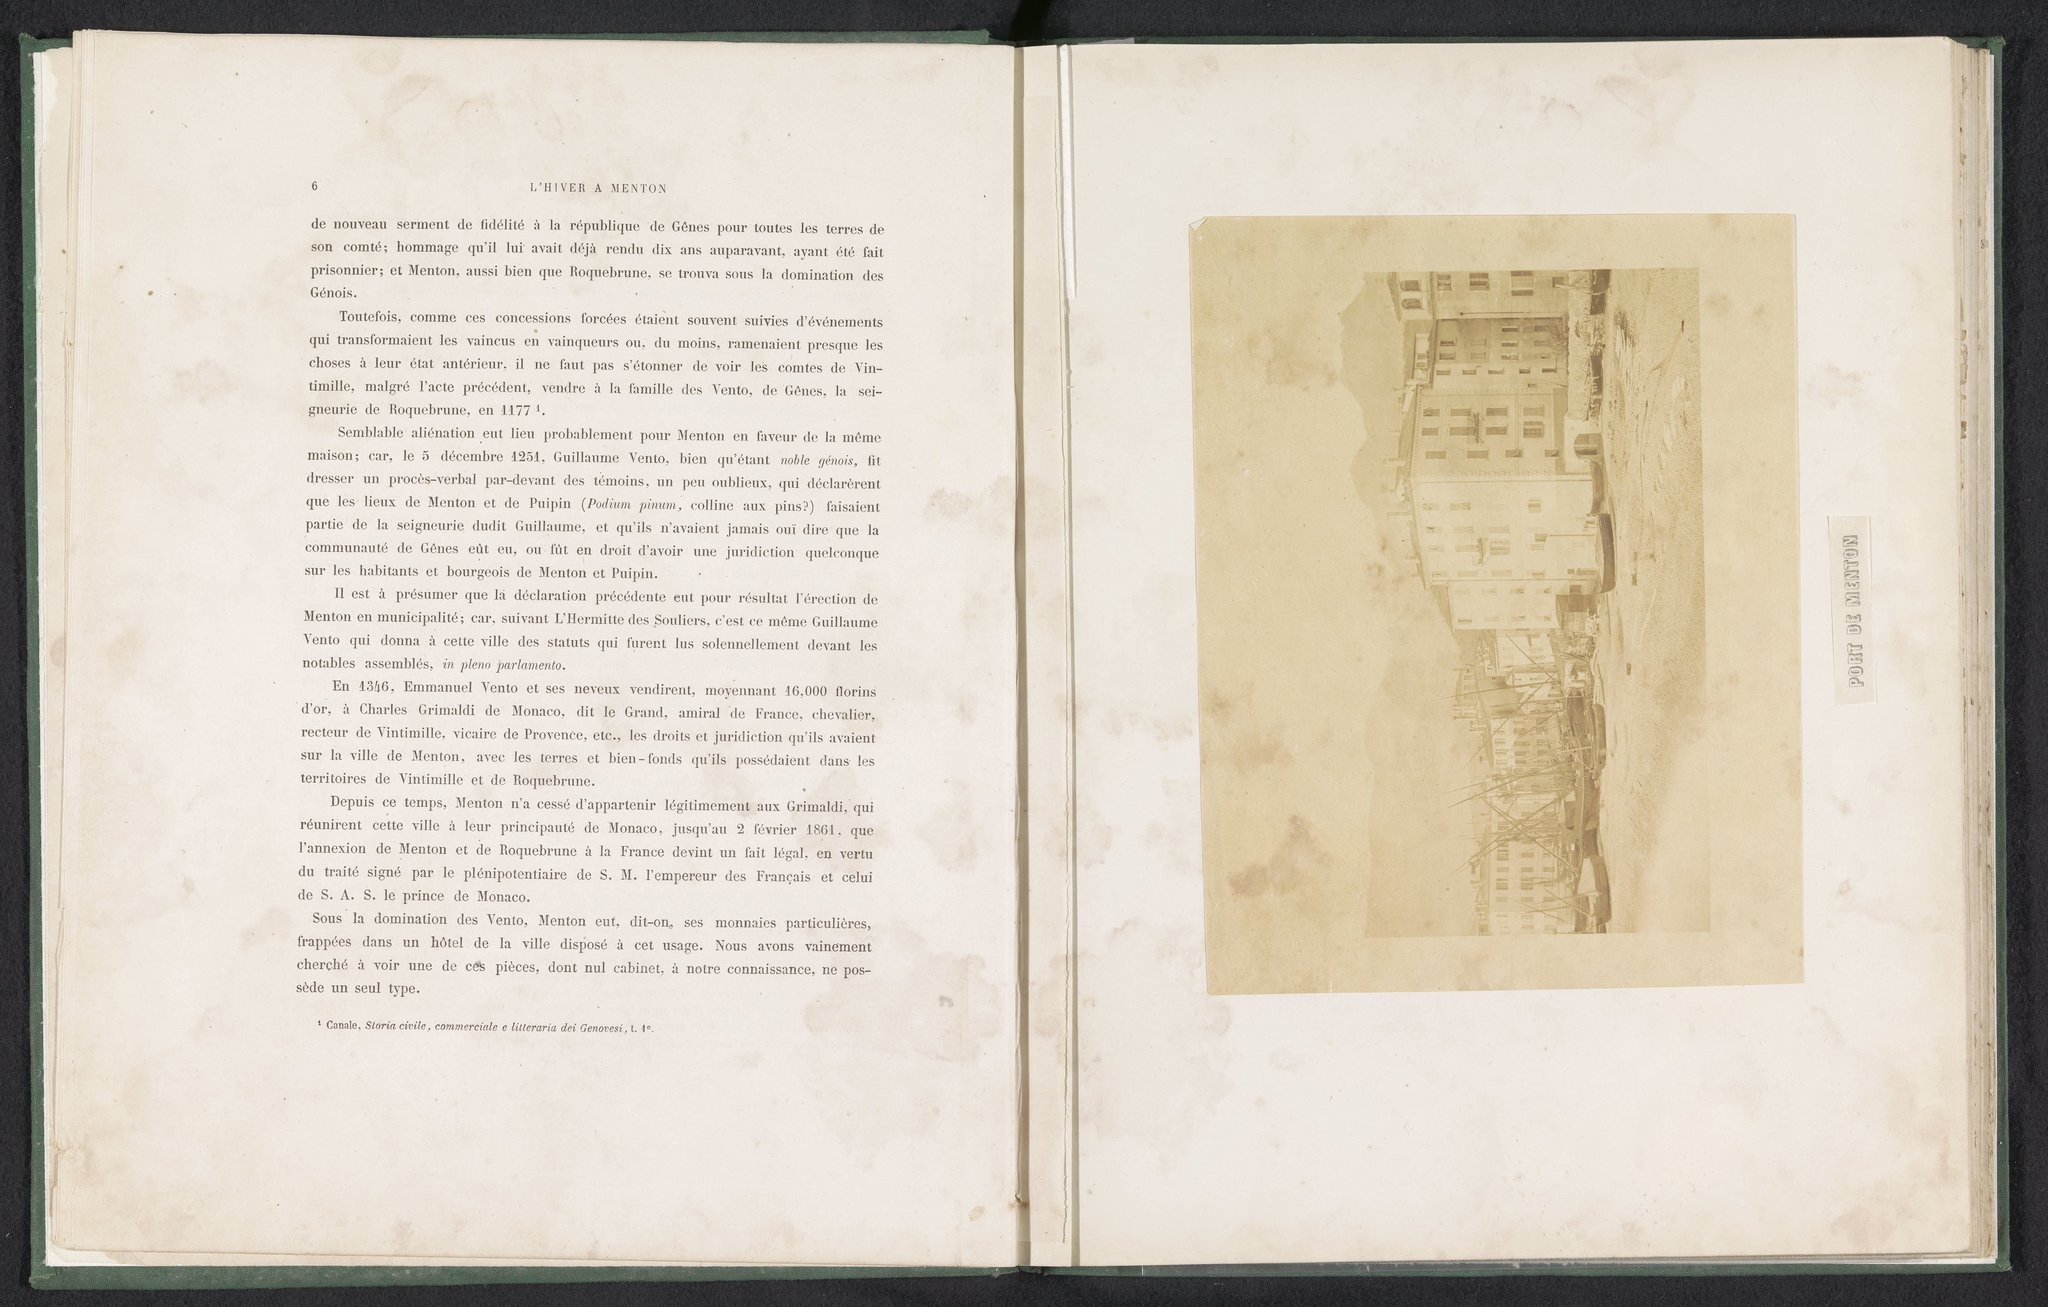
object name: photograph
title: Gezicht op de haven van Menton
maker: louis-alphonse davanne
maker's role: fotograaf, scheikundige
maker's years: 1824-1912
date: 1852-1862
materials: photographic support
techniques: albumen print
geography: menton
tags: harbour, façade (of house or building)